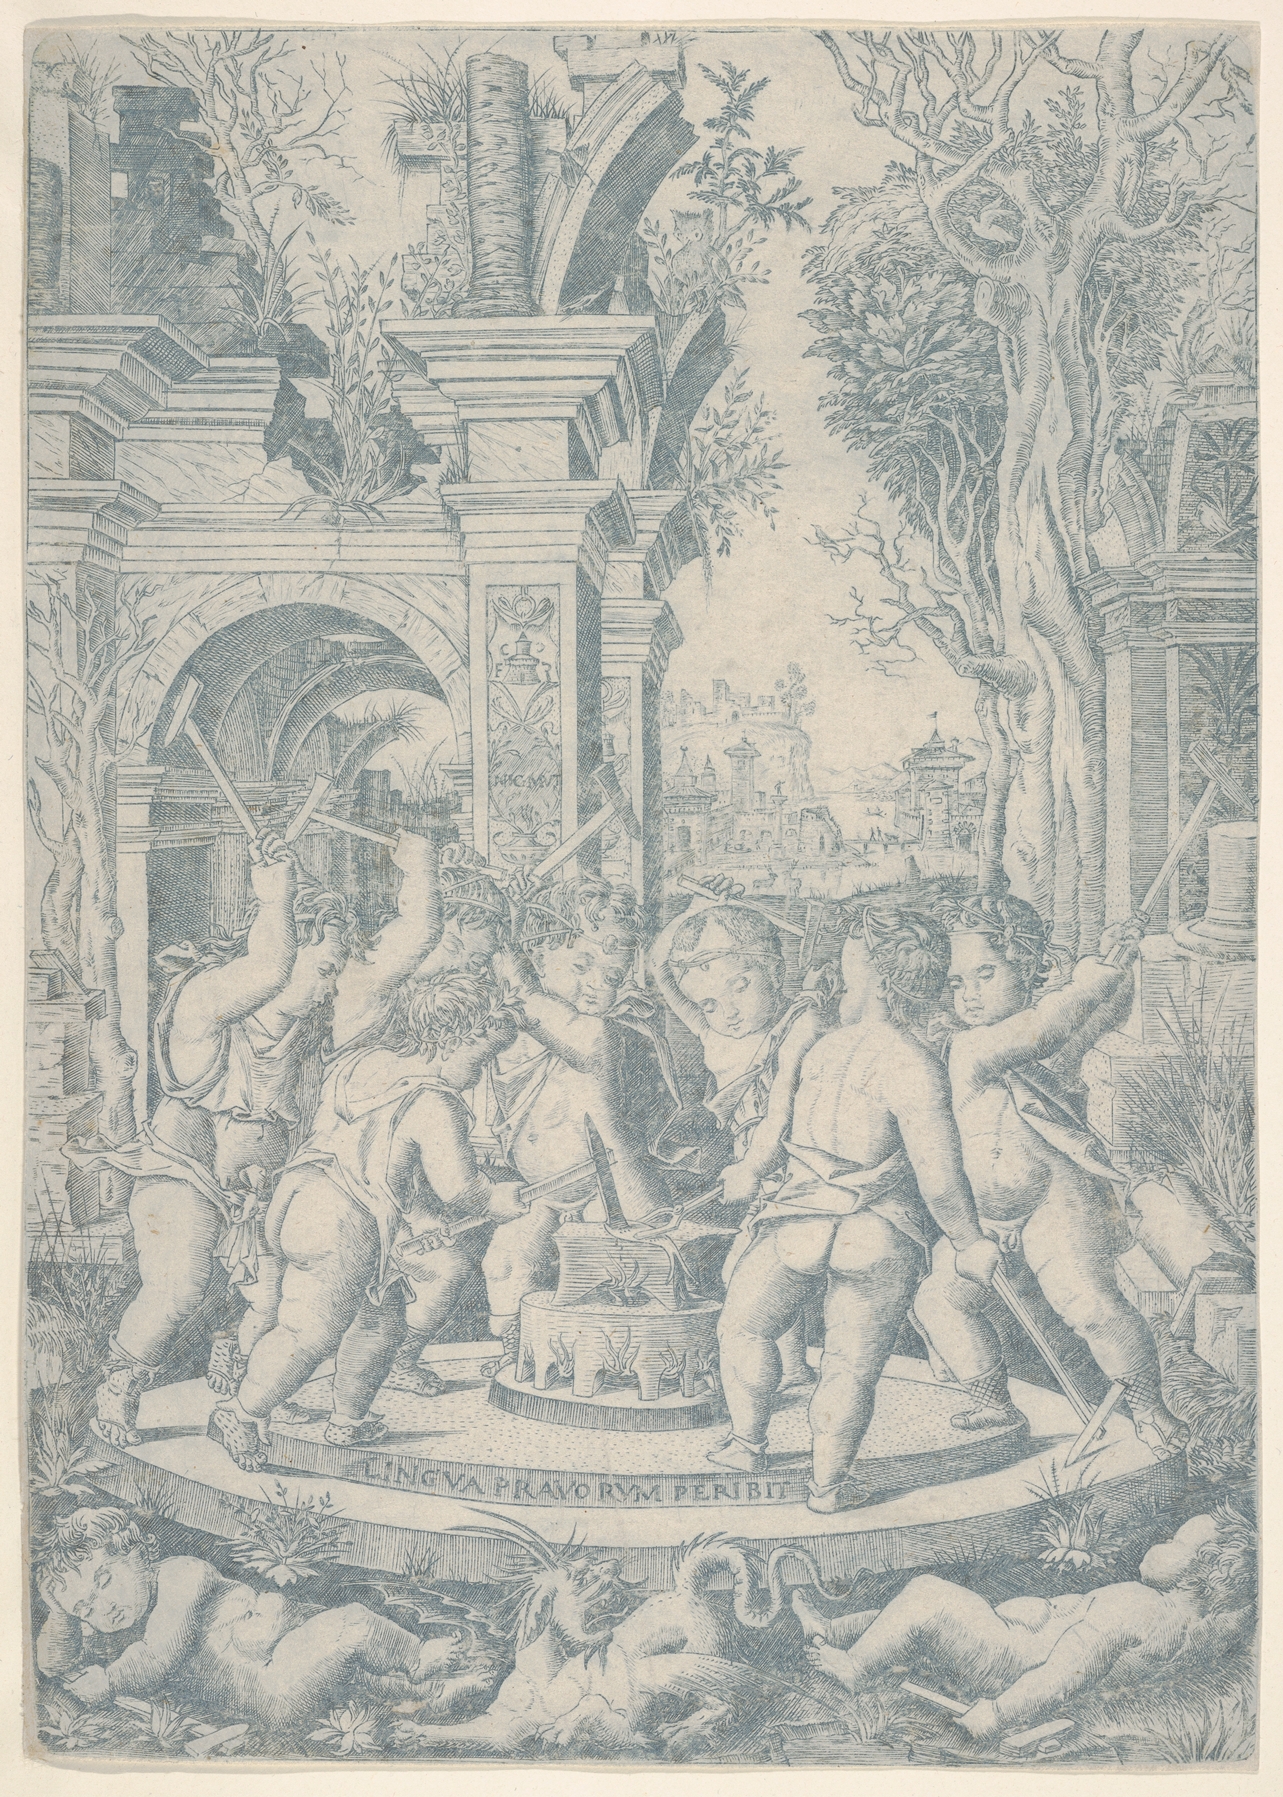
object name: print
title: The fate of an evil tongue; seven putti stand around an anvil on which they hammer a tongue, landscape and architecture behind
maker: nicoletto da modena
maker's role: artist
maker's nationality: italian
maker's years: 1500-1520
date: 1507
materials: ink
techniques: engraving, printing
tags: putti,hammers